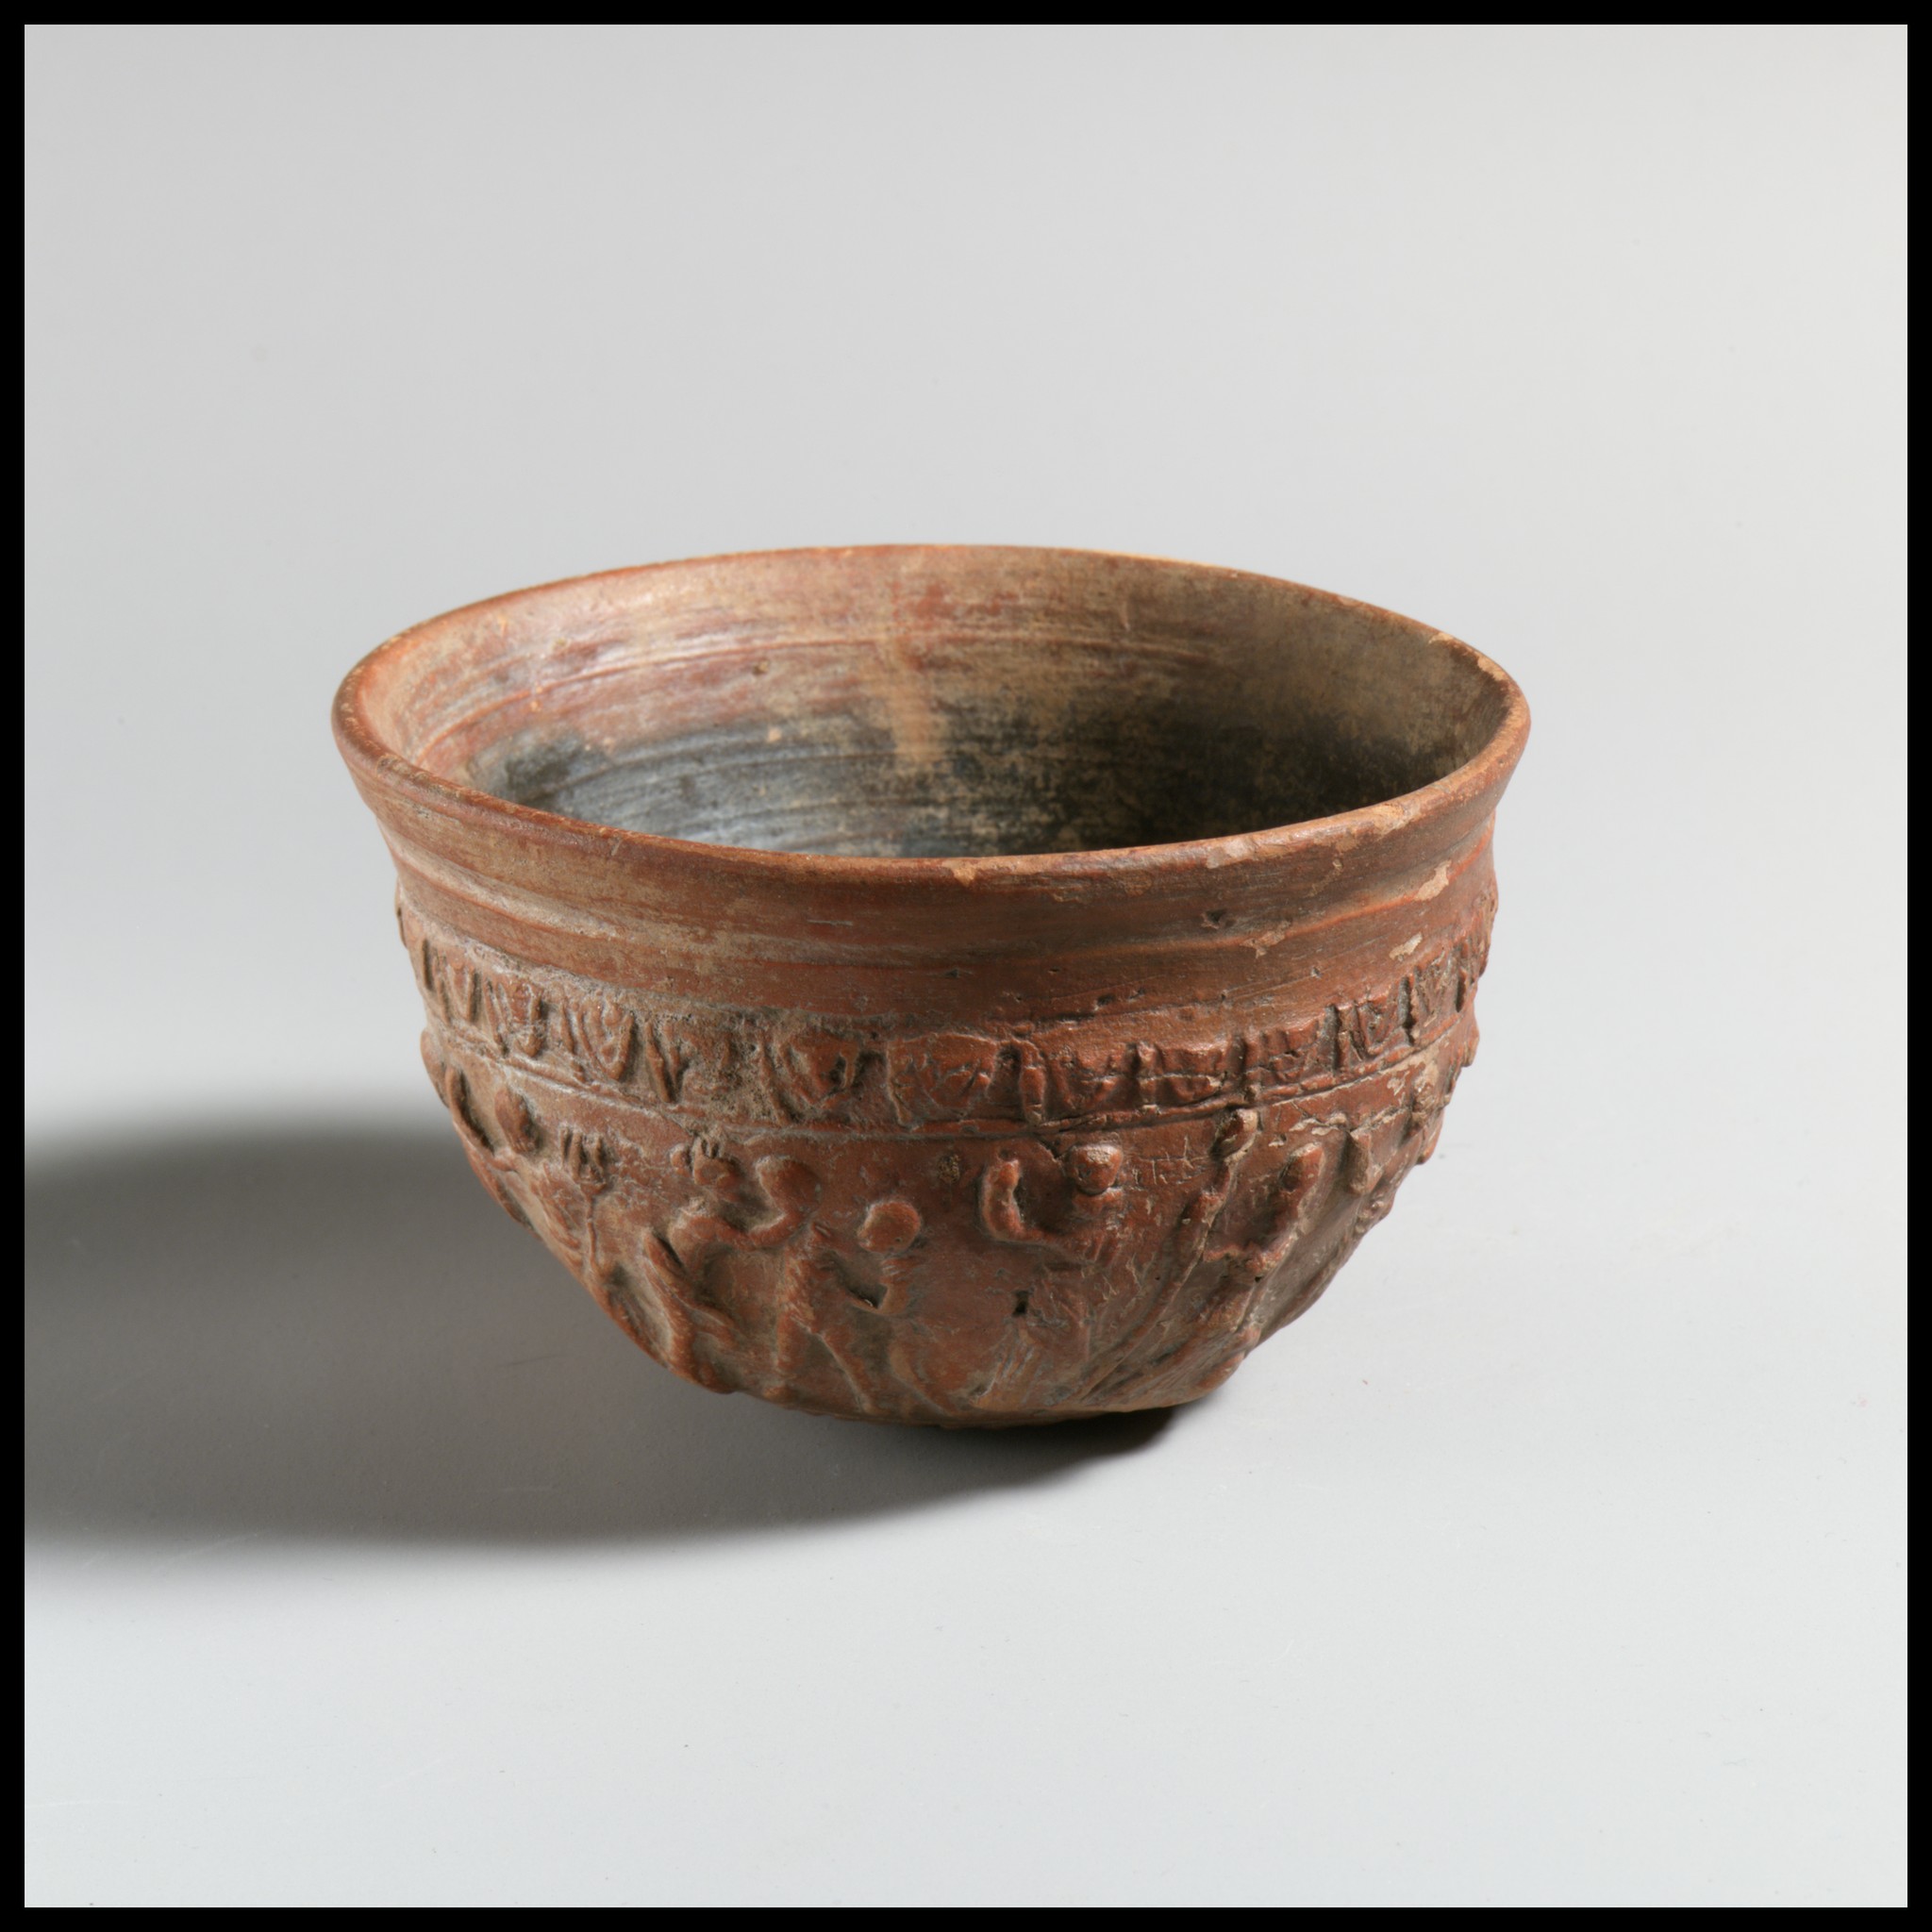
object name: megarian bowl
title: Terracotta Megarian bowl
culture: greek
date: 200-101 BCE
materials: terracotta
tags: dionysus,nike,poseidon,ariadne